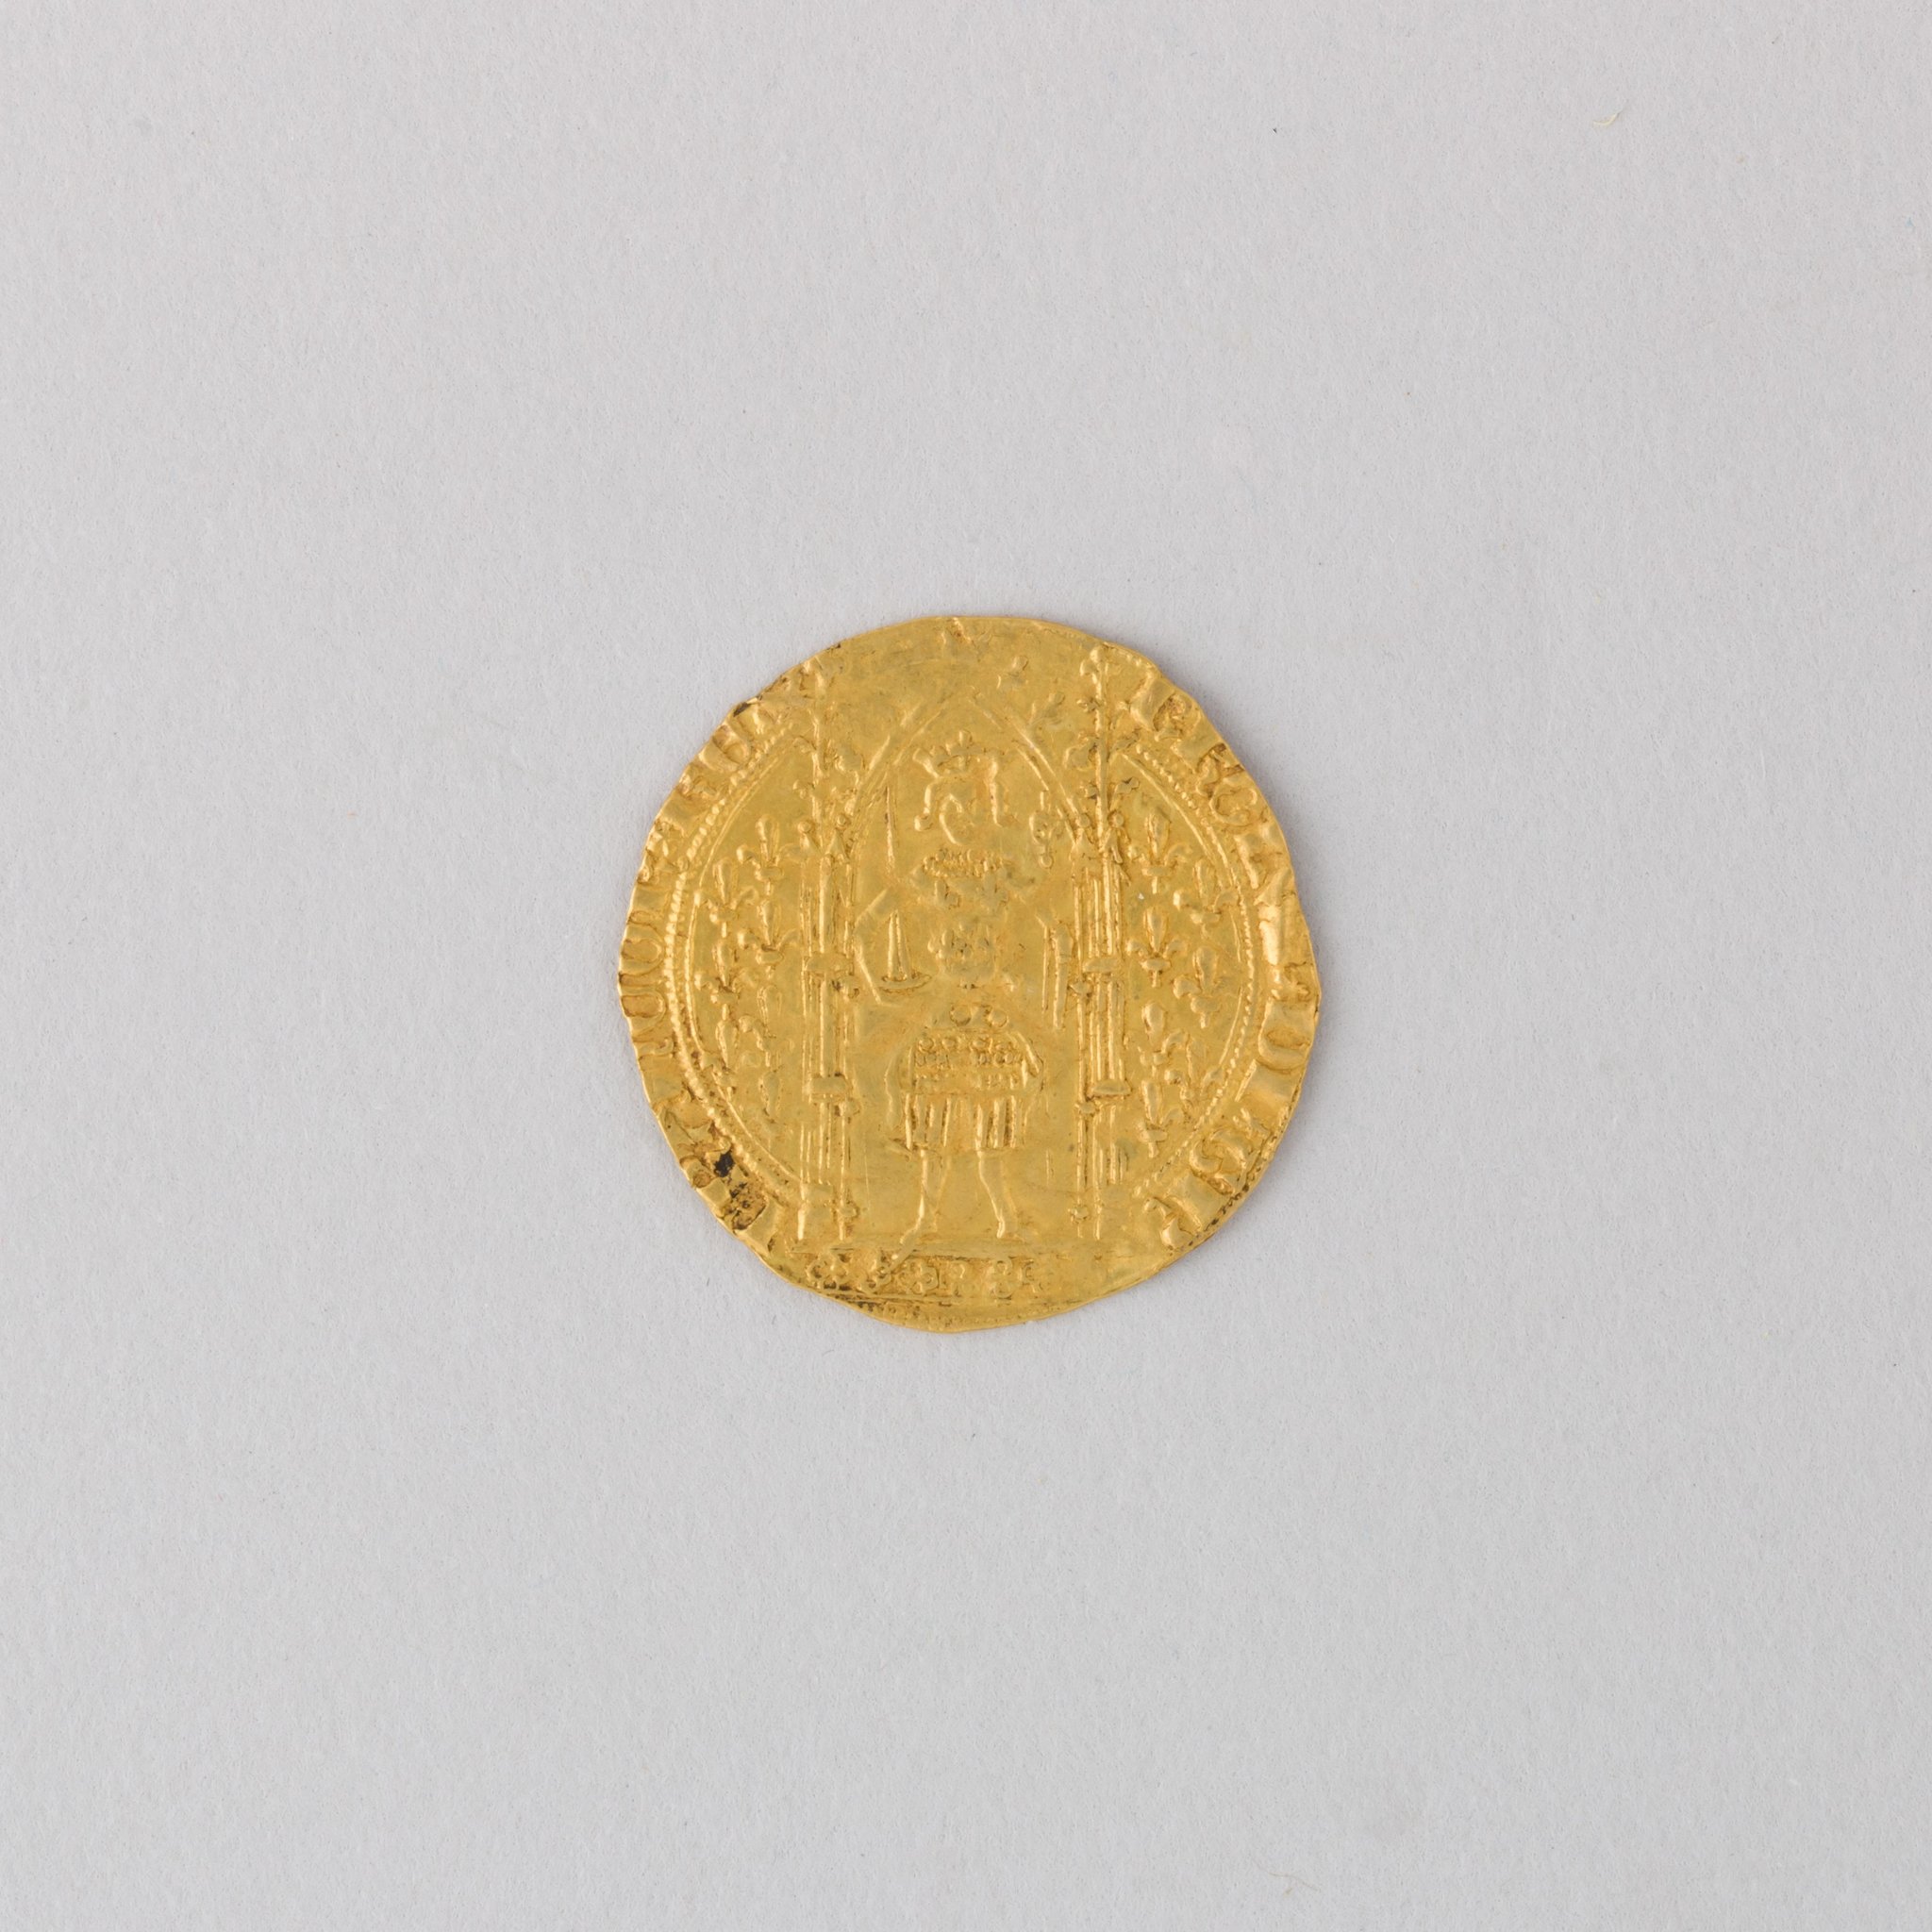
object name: coin franc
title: Coin (Franc) Showing Charles V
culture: french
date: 1301-1400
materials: gold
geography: france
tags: coins